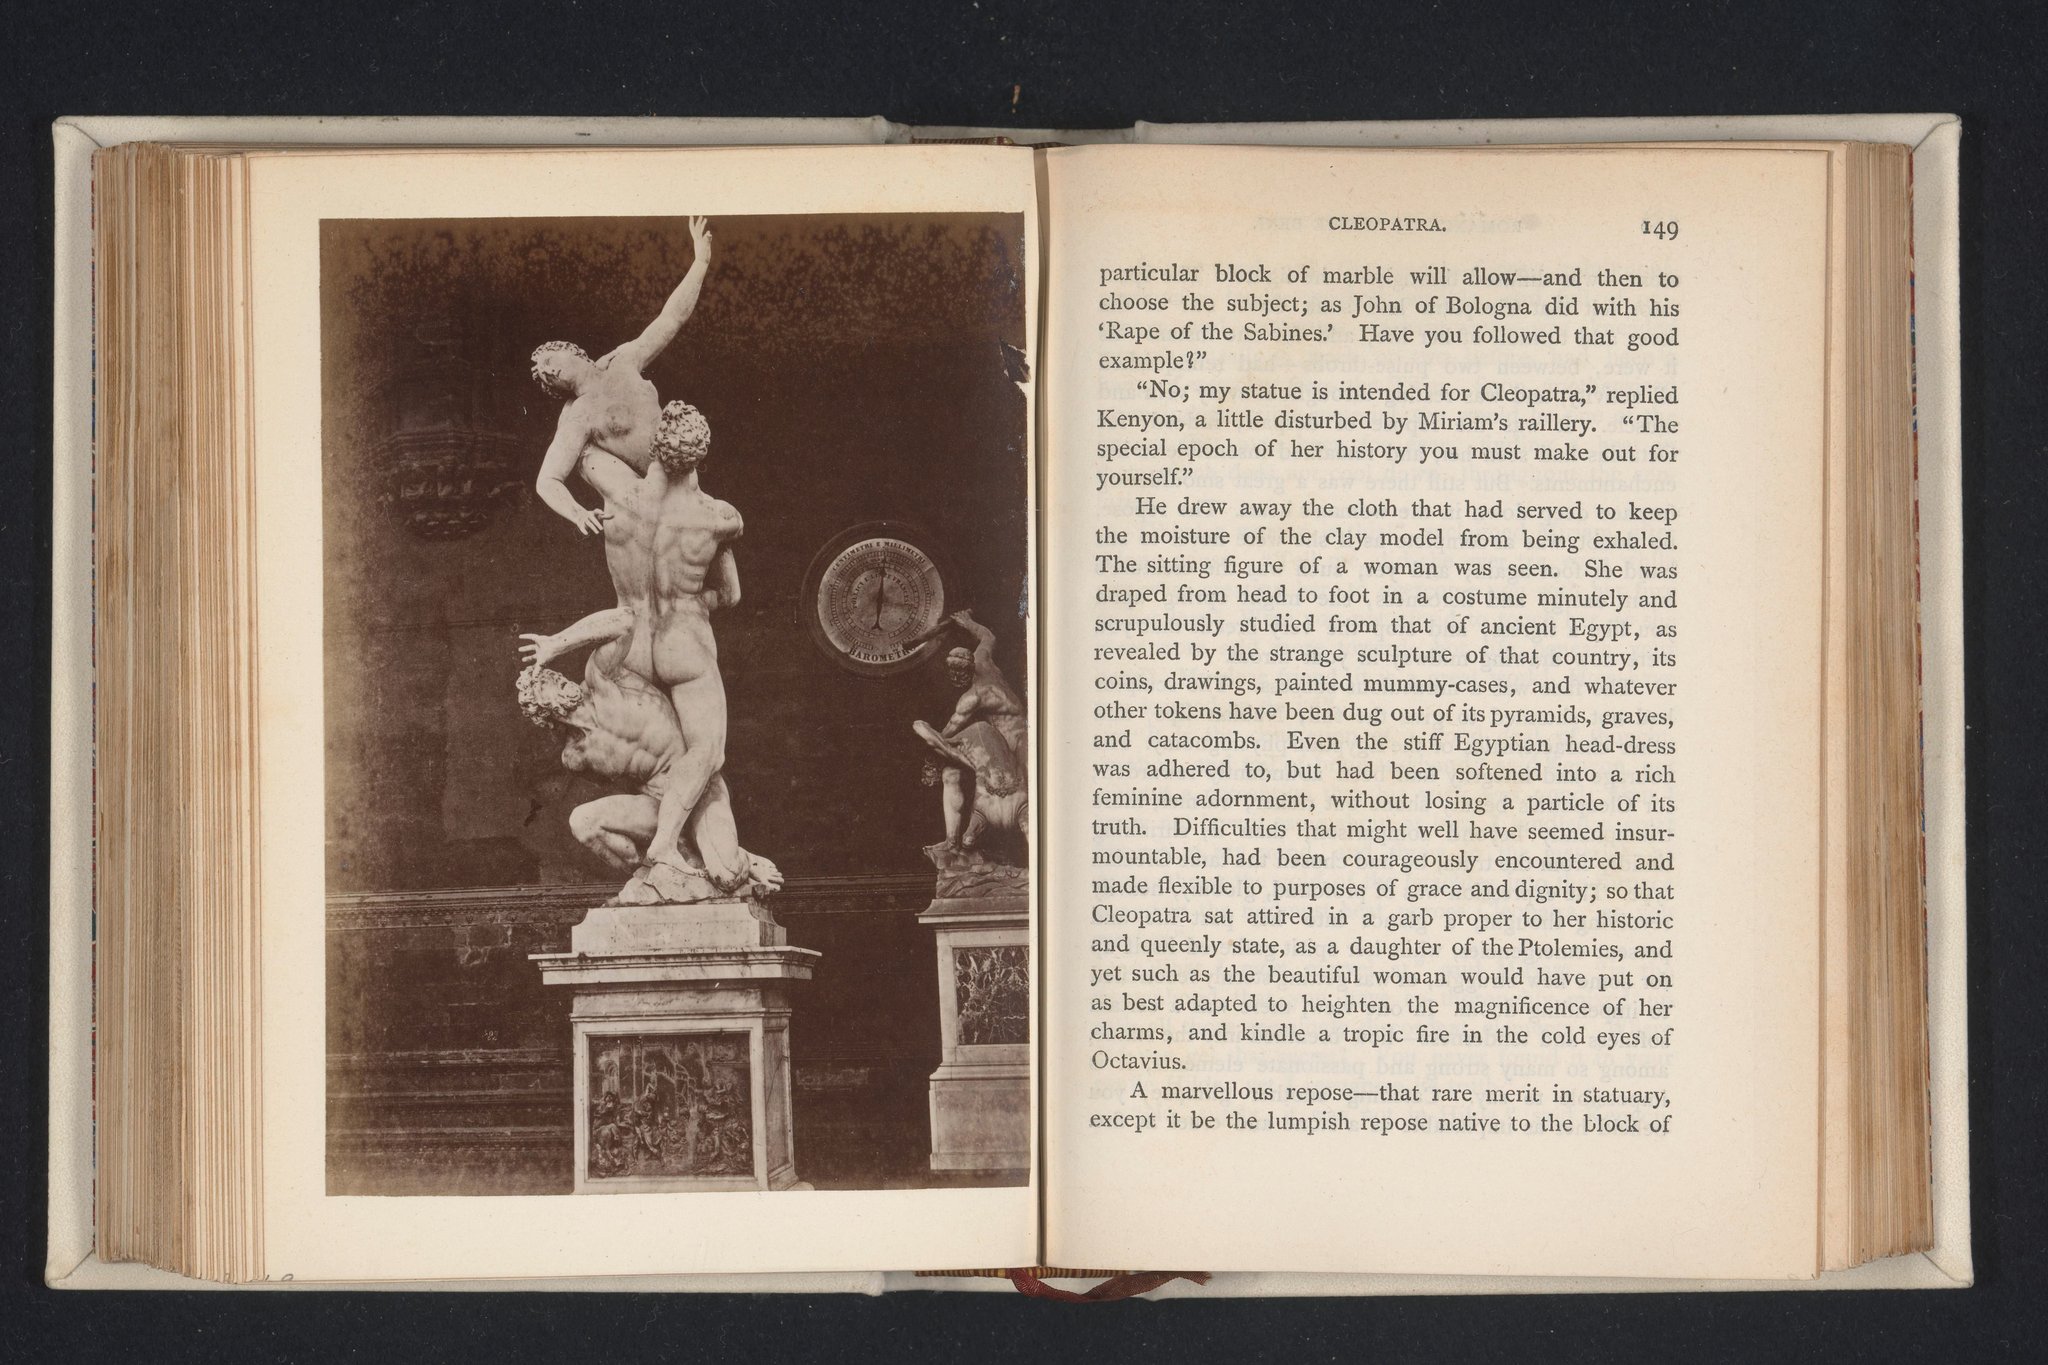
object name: page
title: Sabijnse Maagdenroof door Giambologna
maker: Anonymous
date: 1850-1860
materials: photographic support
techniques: albumen print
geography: italy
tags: rape of the sabine women: they are carried off by romulus and his men during a feast, piece of sculpture, reproduction of a piece of sculpture